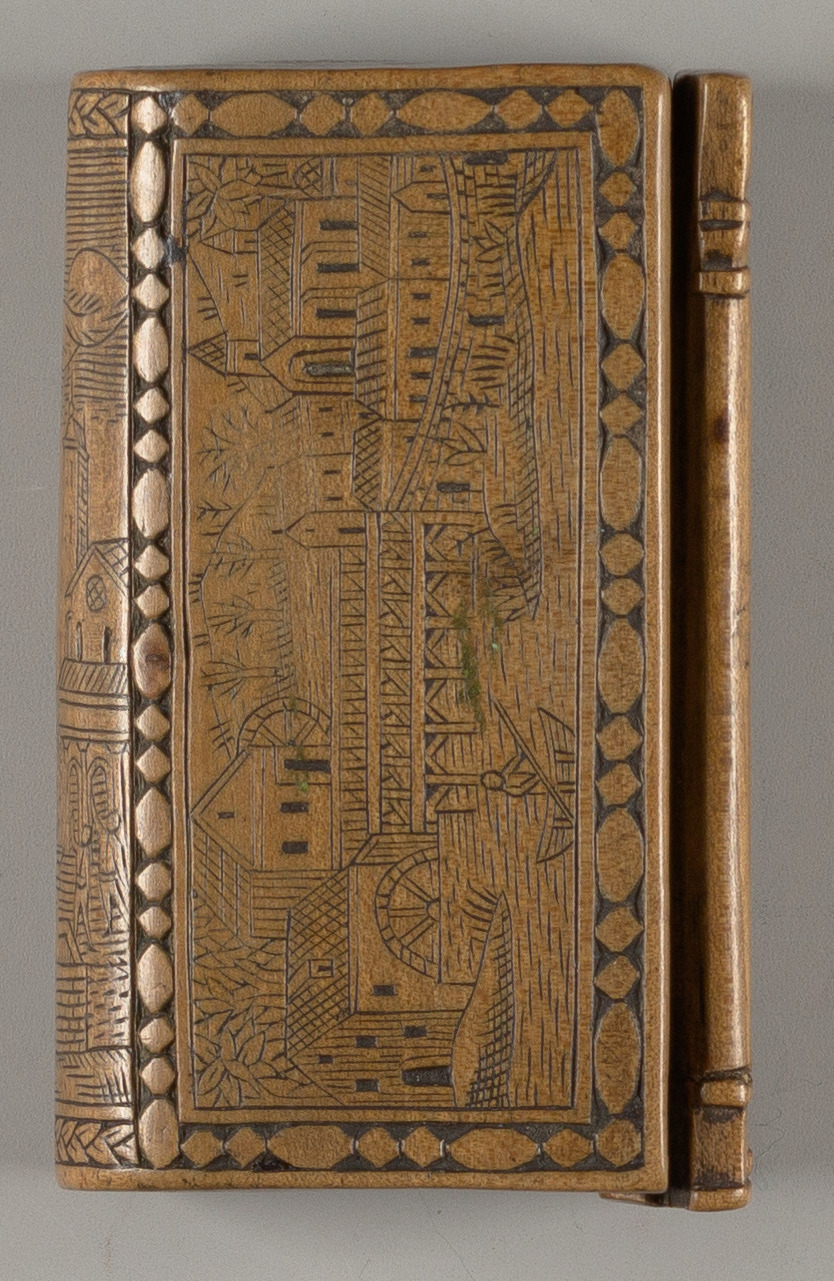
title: Box in book form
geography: europe